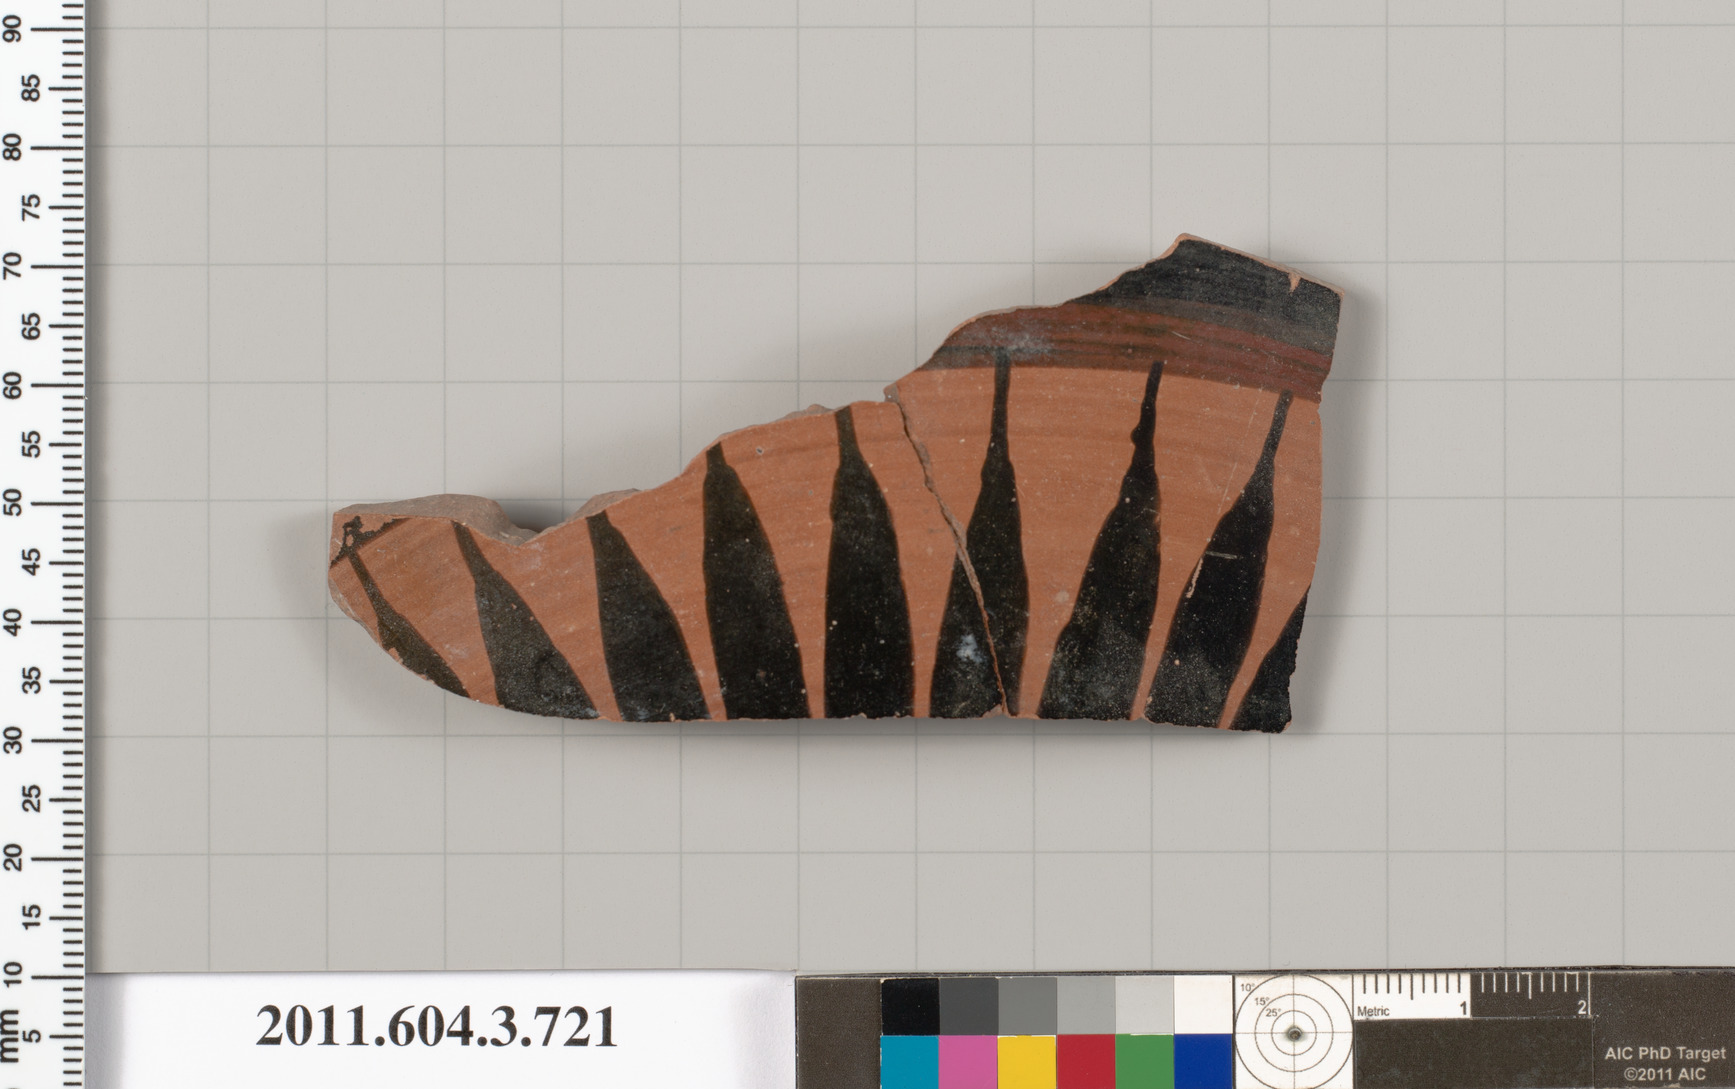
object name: hydria fragment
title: Terracotta fragment of a hydria (water jar)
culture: greek, attic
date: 534-468 BCE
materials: terracotta